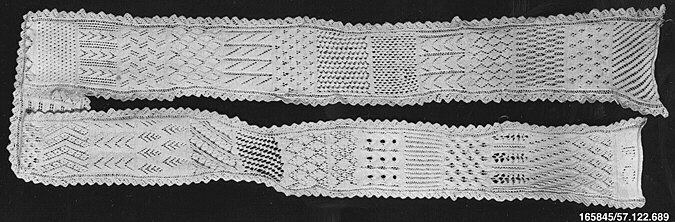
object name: sampler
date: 1801-1900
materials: lace, wool